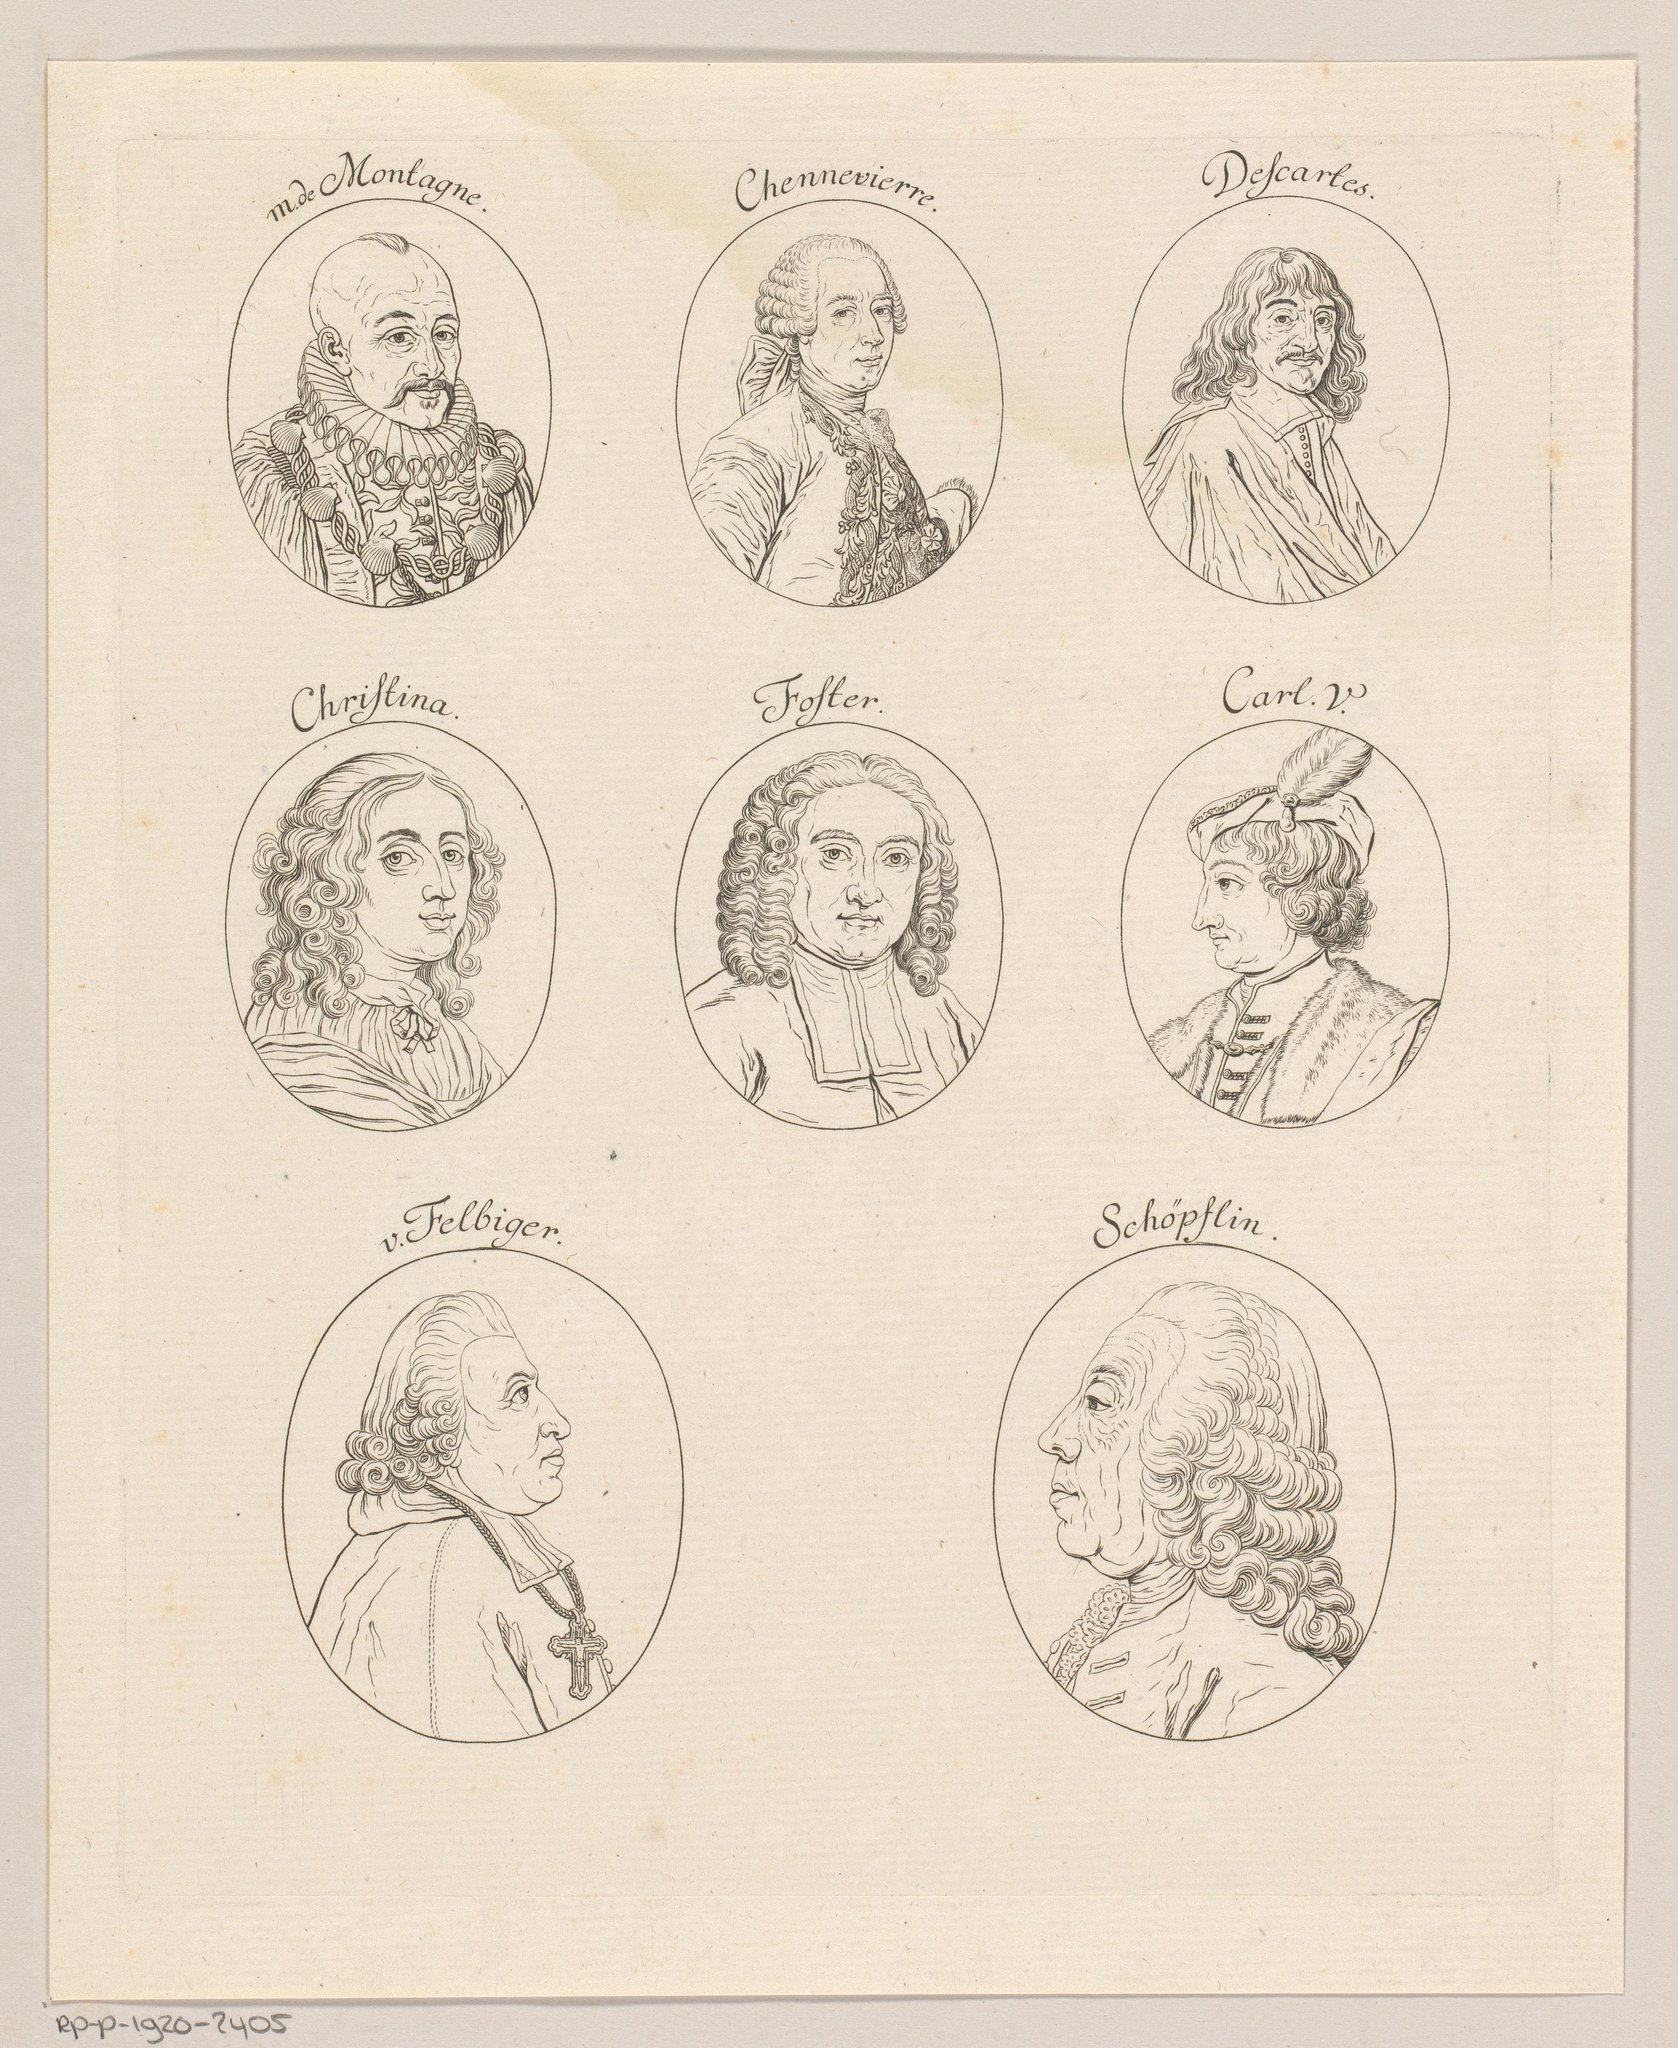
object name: print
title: Portret van Michel Eyquem de Montaigne en zeven anderen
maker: Anonymous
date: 1786-1835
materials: paper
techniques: engraving, etching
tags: rené descartes, rome, christina (koningin van zweden), michel eyquem de montaigne, historical persons - bb - woman, historical persons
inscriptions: collector's mark: Lugt 2228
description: Originele prent uit: Lavater, Johann Caspar. Essai sur la physiognomonie (...). Den Haag: Karnebeek, 1786. Waarschijnlijk komt deze prent uit een latere editie die tot circa 1835 zijn uitgegeven.